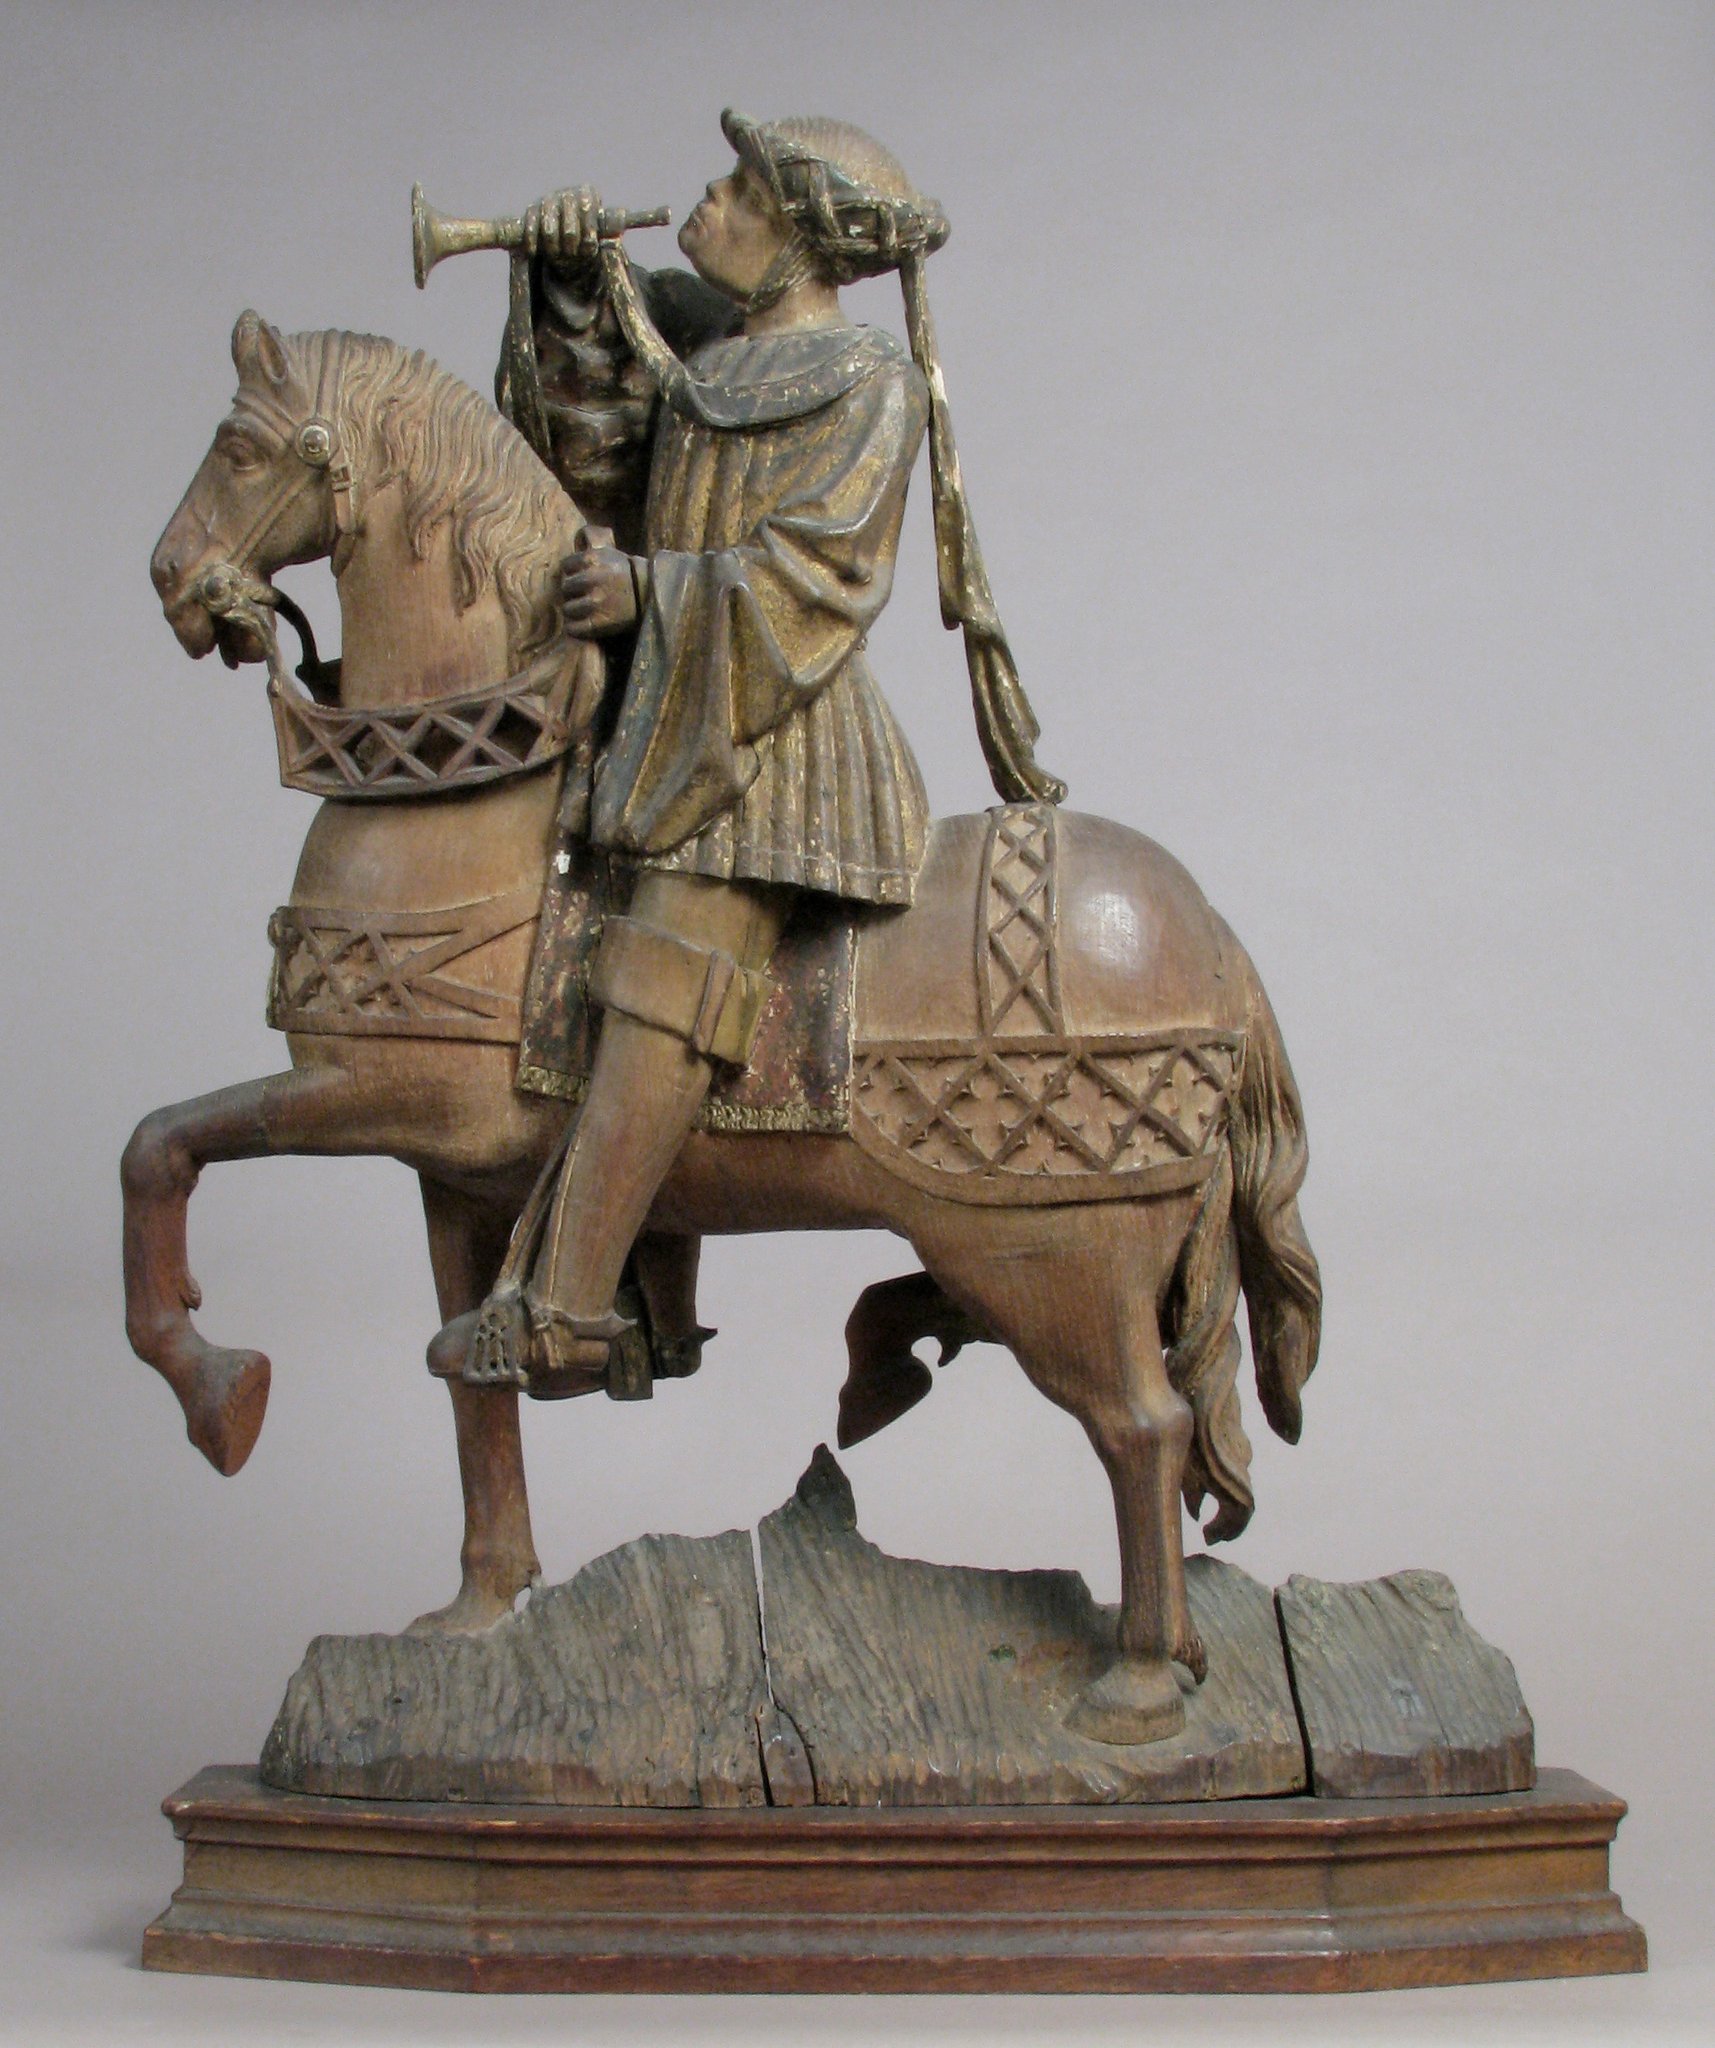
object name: statuette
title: Trumpeter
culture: south netherlandish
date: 1500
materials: wood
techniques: gilding, polychromy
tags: men,horses,musicians